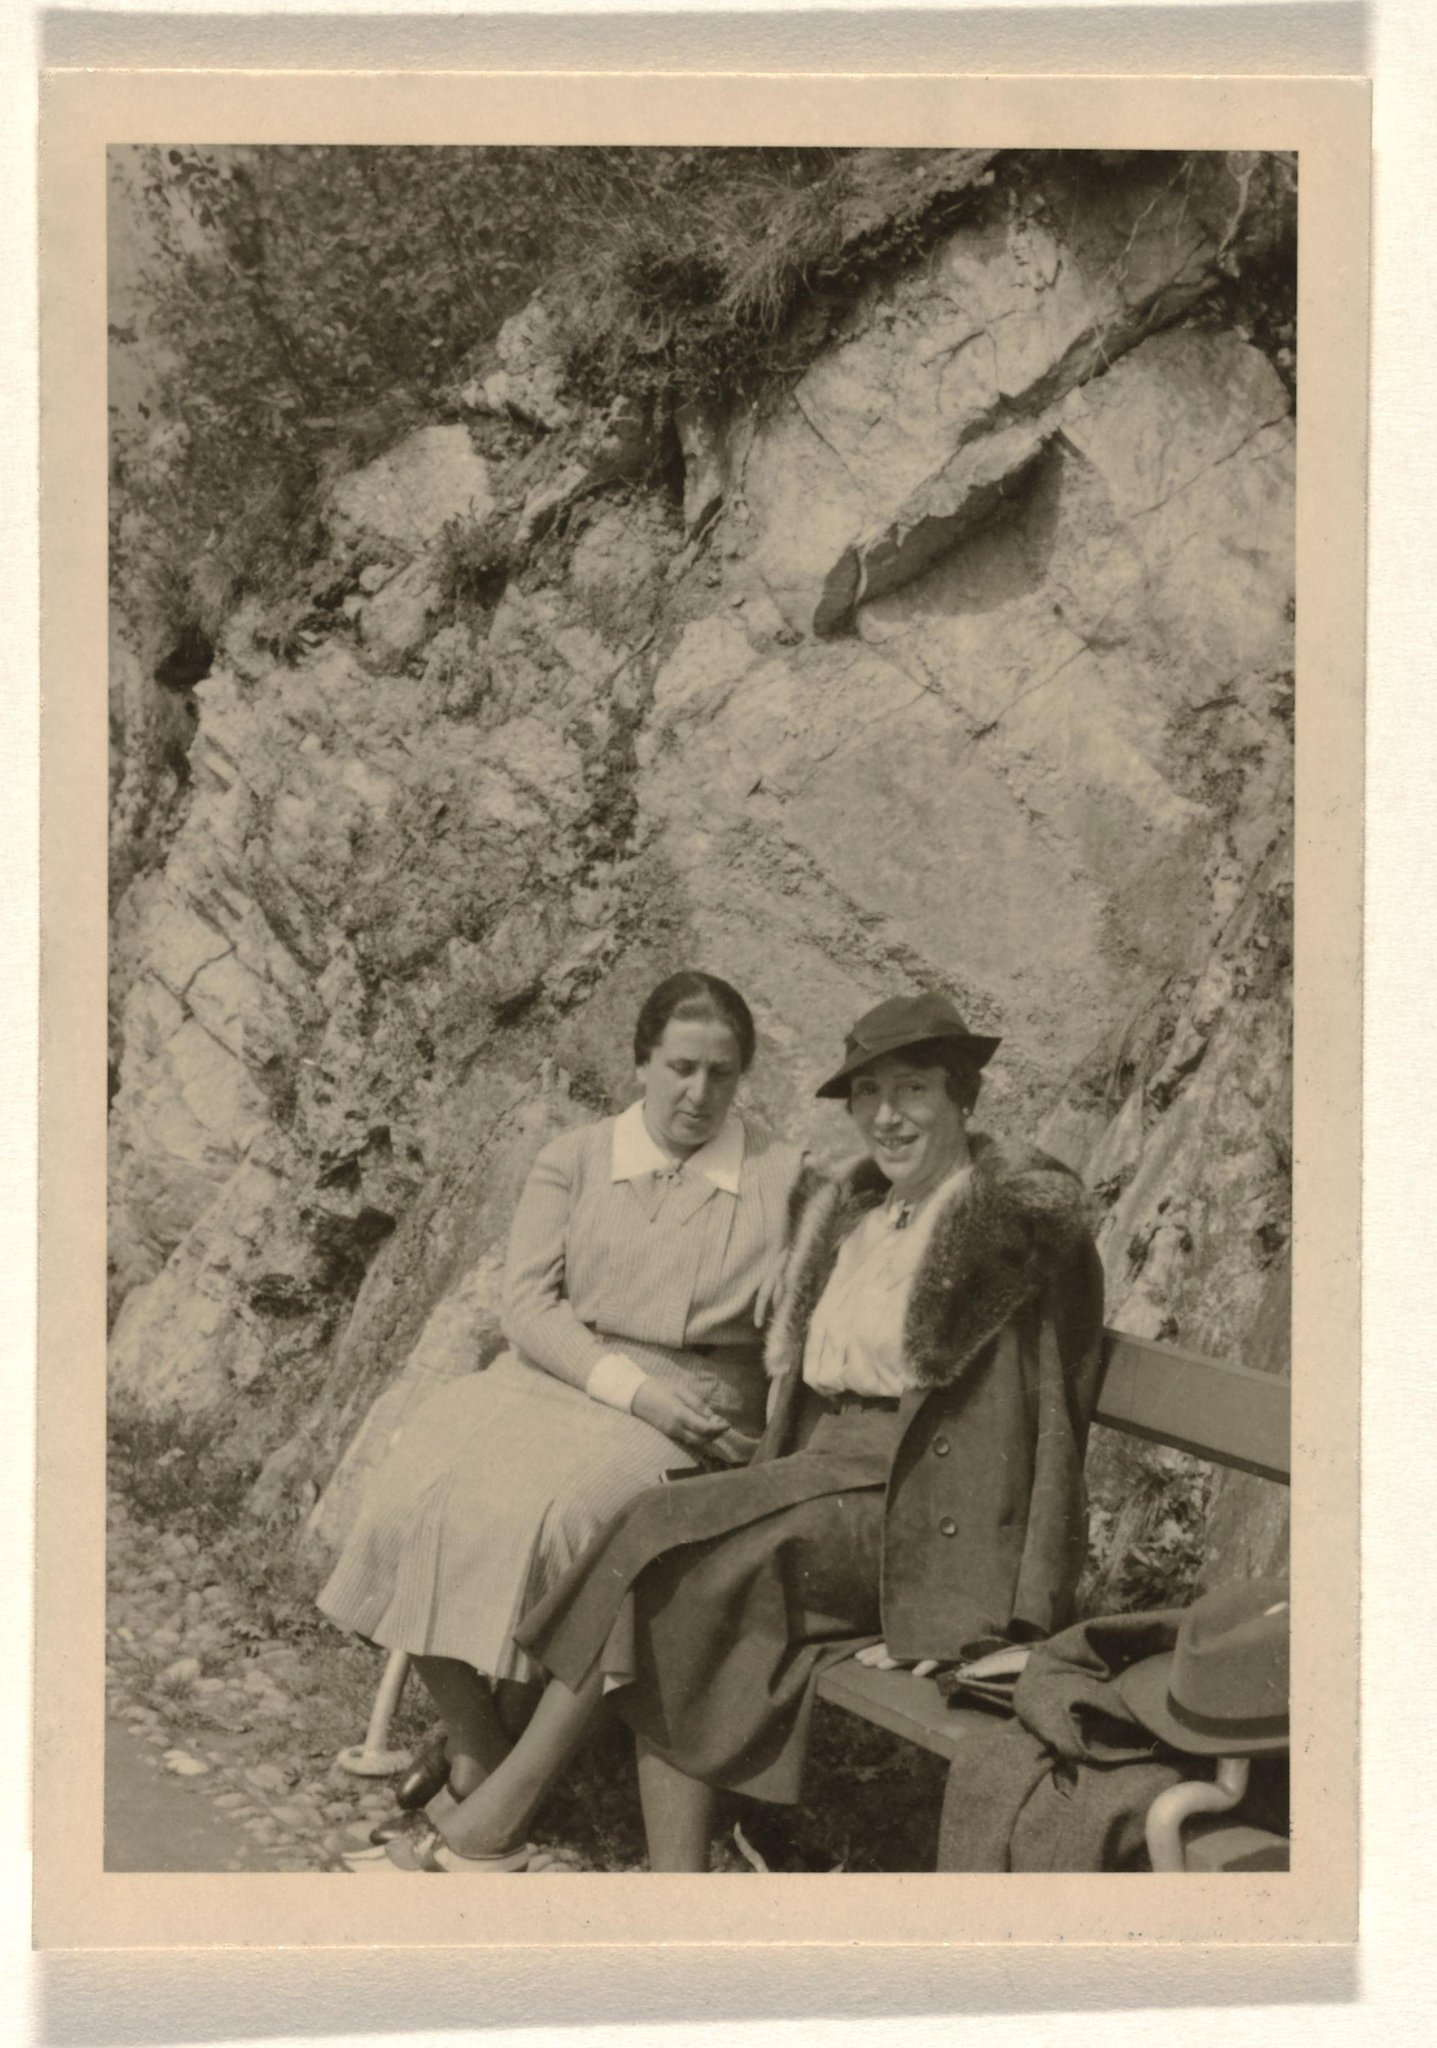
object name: photograph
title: Else Wachenheimer-Moos met een onbekende vrouw, gezeten voor een rotswand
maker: Anonymous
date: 1925-1937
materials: photographic support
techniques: gelatin silver print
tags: else wachenheimer-moos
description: Else Wachenheimer-Moos (links) in lichte kleding met kraag en een onbekende vrouw (rechts) met hoed en bontkraag, gezeten op een bankje met een jas over het bankje gedrapeerd, voor een rotswand.